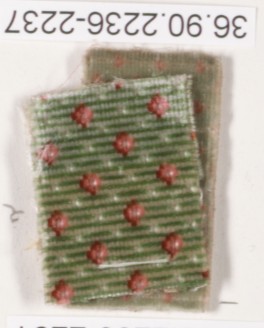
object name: piece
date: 1801-1900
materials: silk